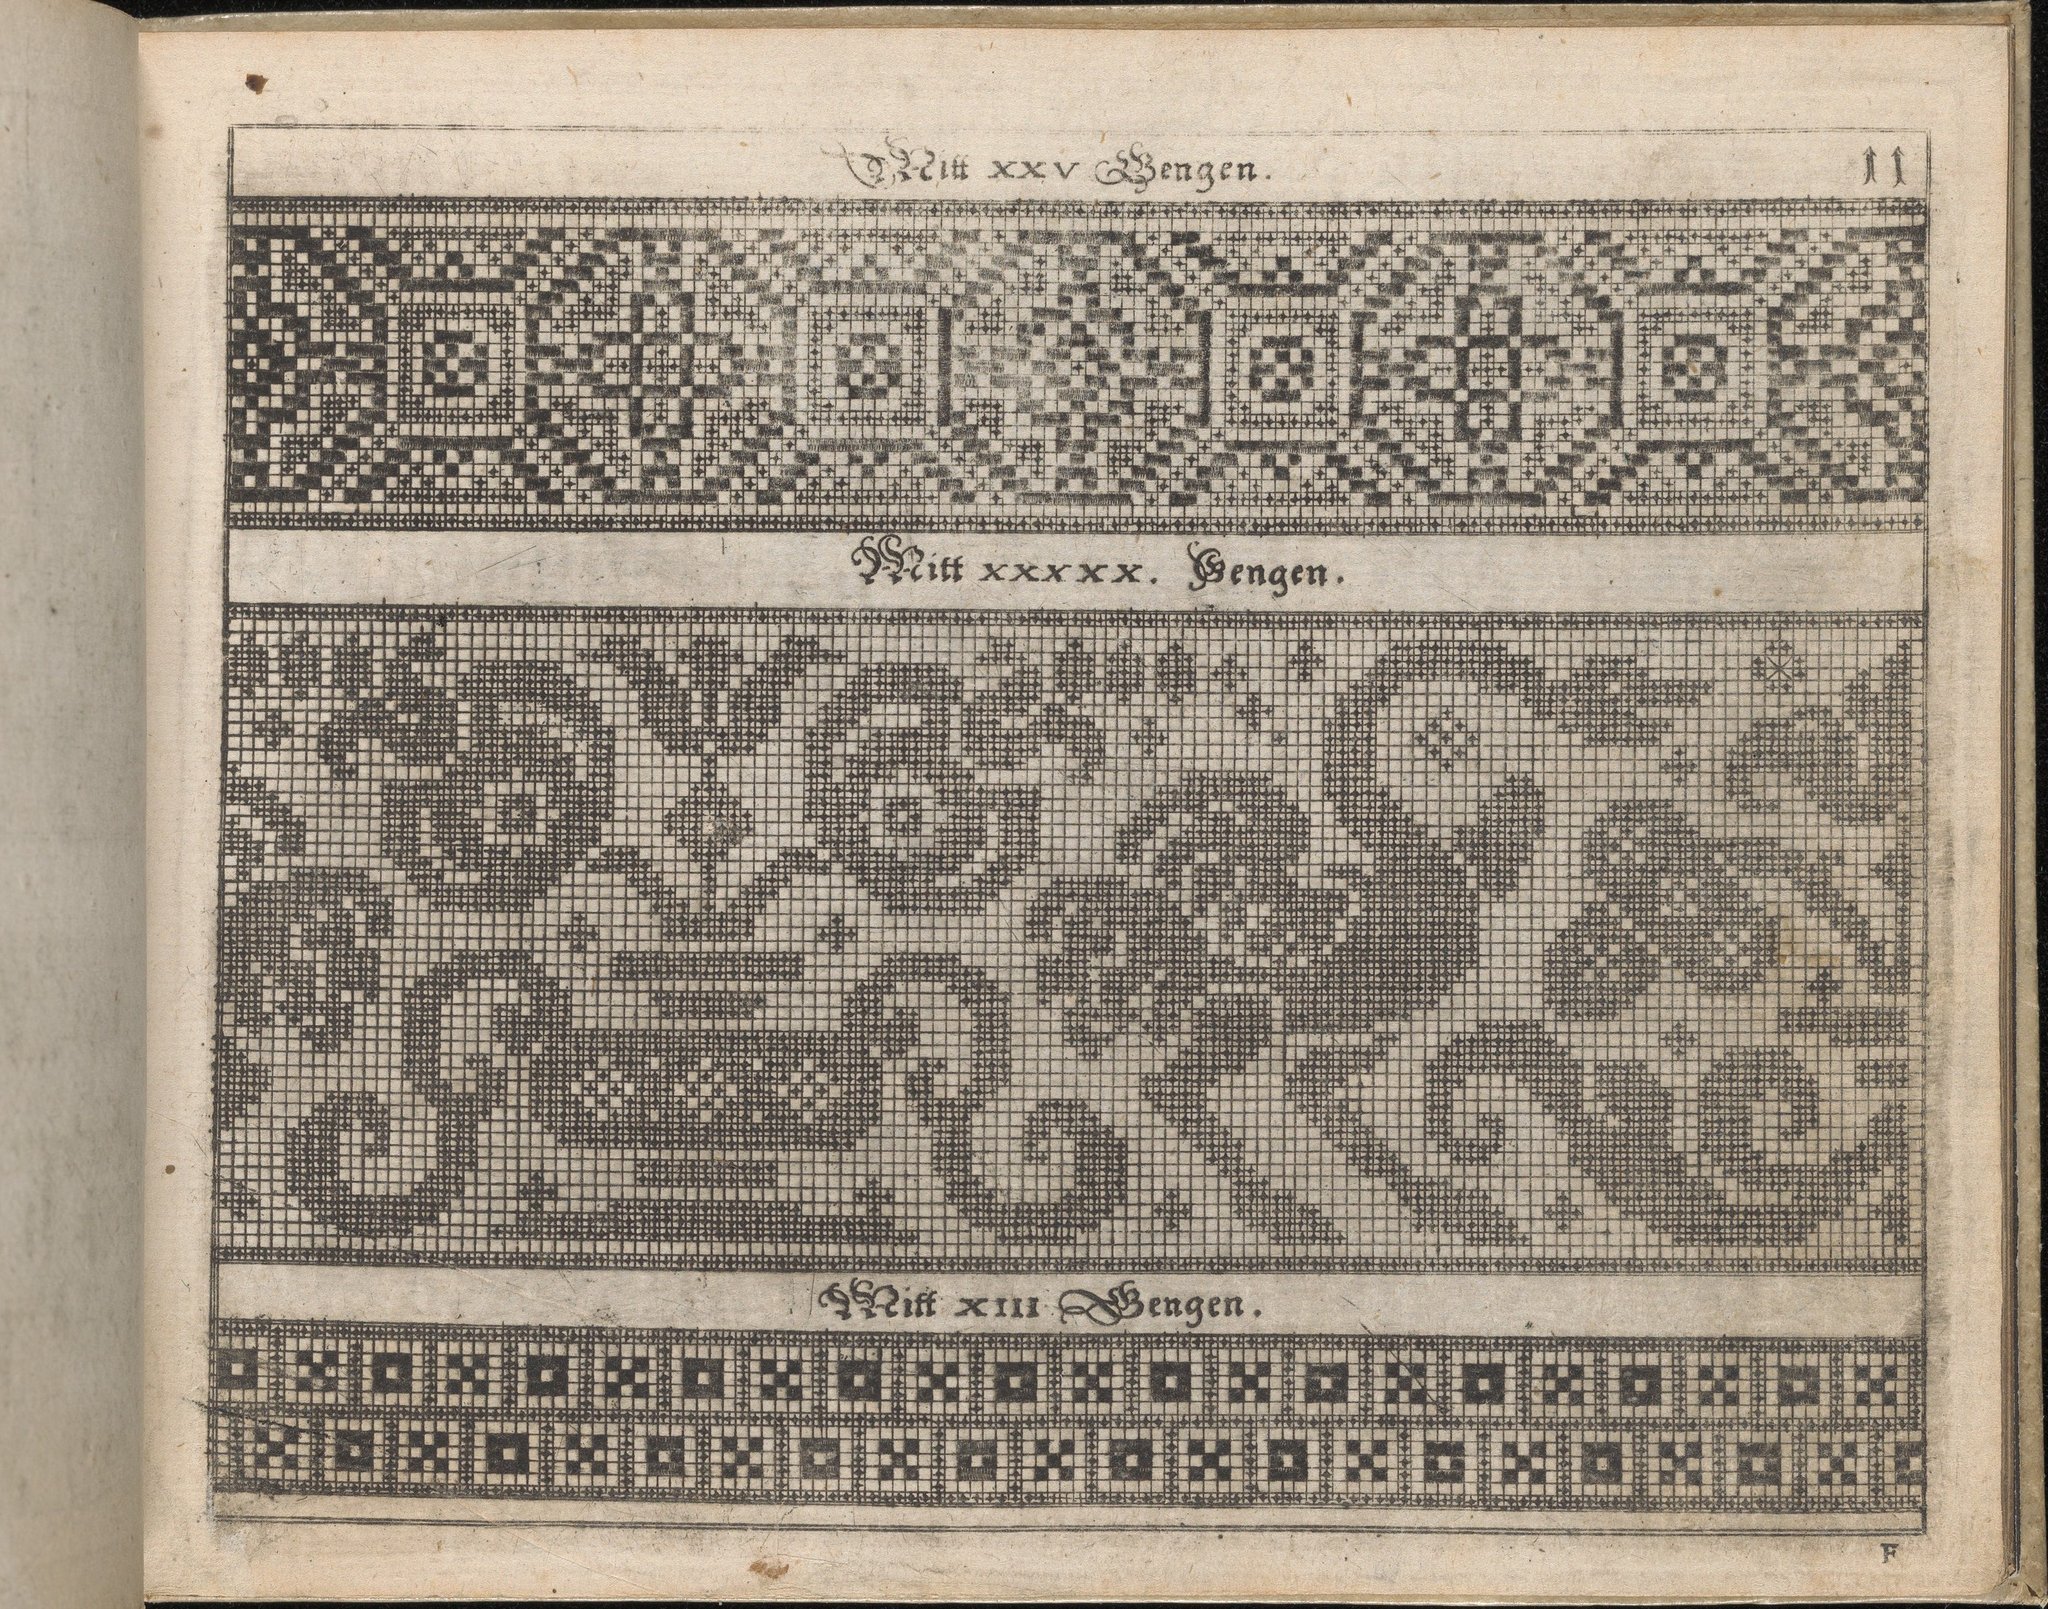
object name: book print ornament architecture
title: Newes Modelbuch in Kupffer (Page 20r)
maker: johann sibmacher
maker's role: artist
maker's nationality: german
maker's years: 1590-1611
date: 1604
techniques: etching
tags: birds